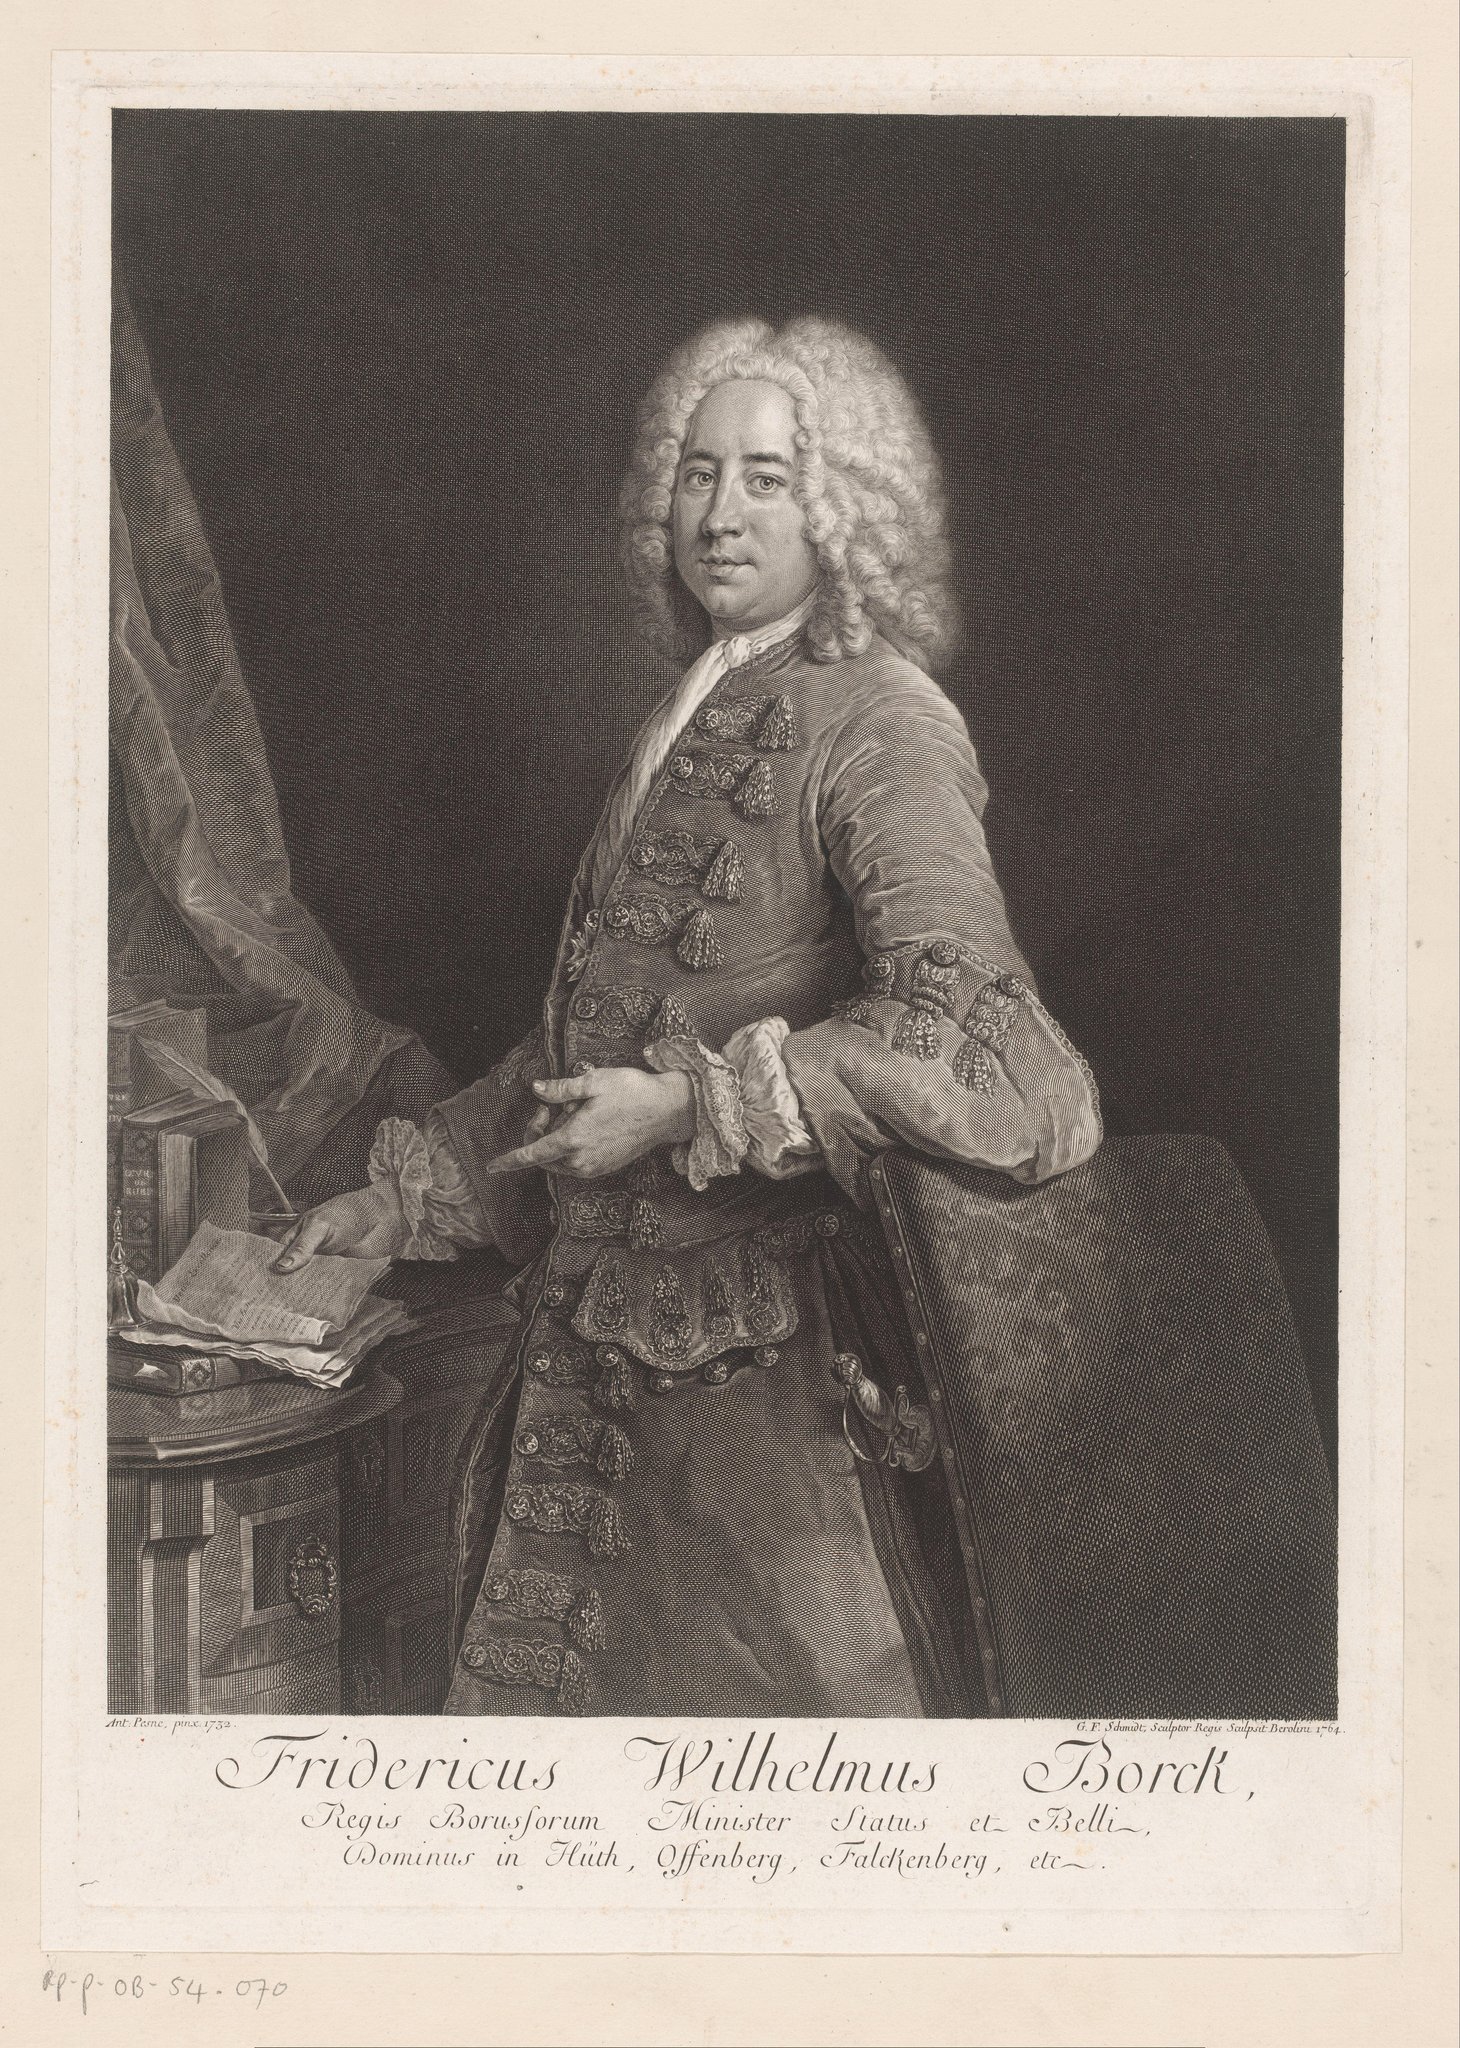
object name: print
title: Portret van Friedrich Wilhelm von Borck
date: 1764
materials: paper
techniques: engraving, etching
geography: berlin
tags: berlin, historical persons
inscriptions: collector's mark: Lugt 240